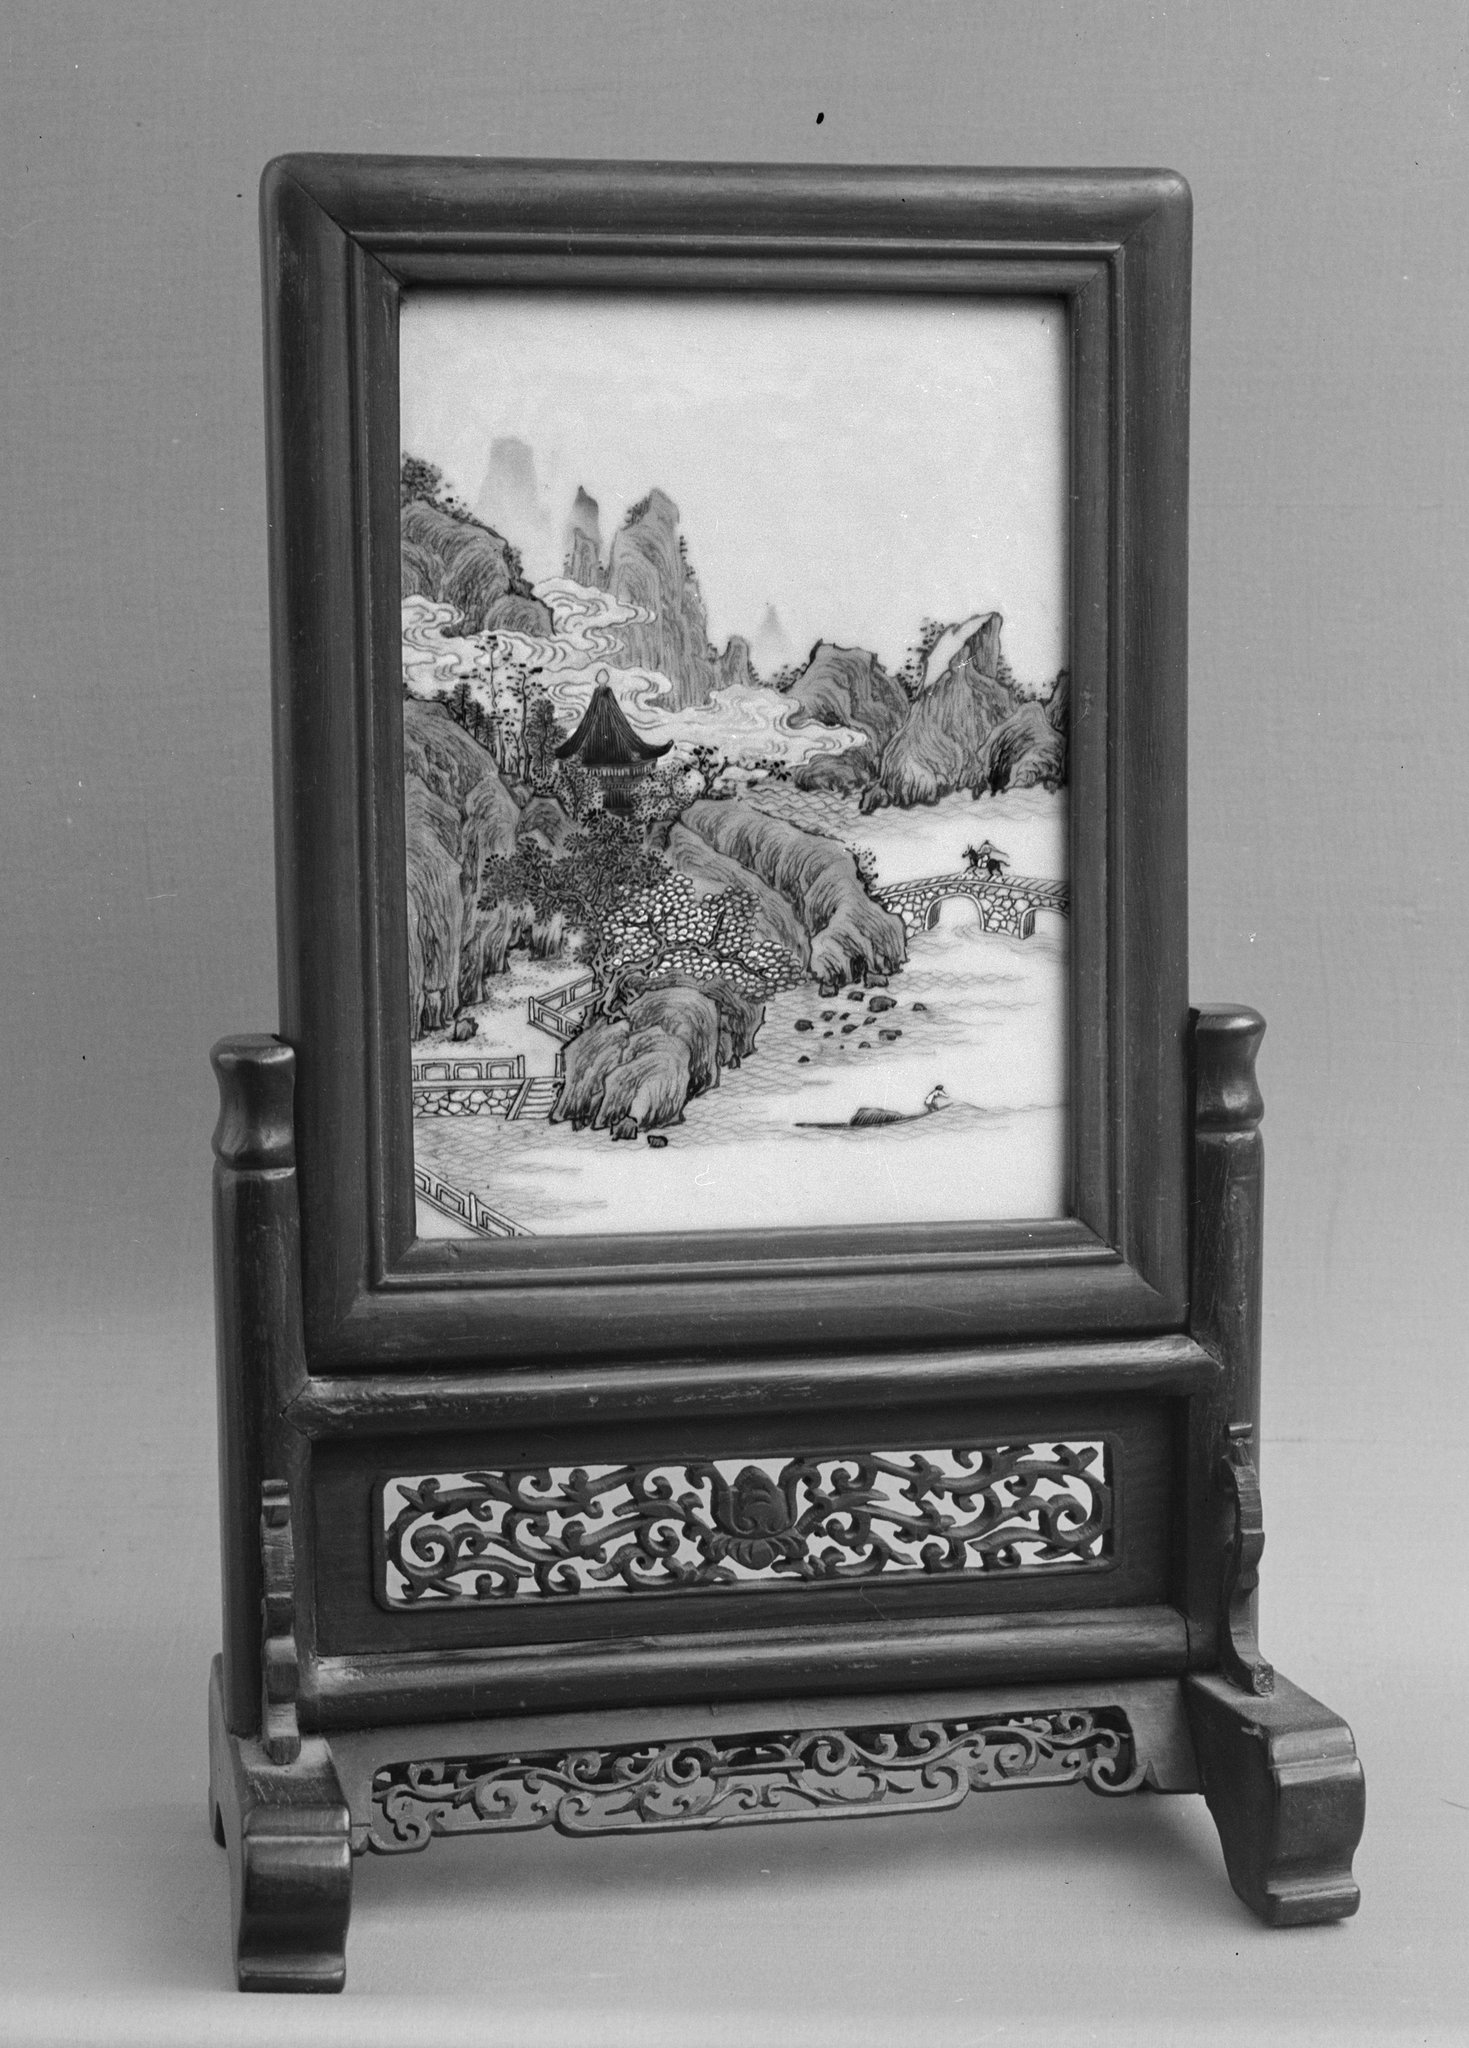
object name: desk screen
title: Desk screen with landscape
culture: chinese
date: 1767-1800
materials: enamel, porcelain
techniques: overglaze, painting, polychrome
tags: landscapes